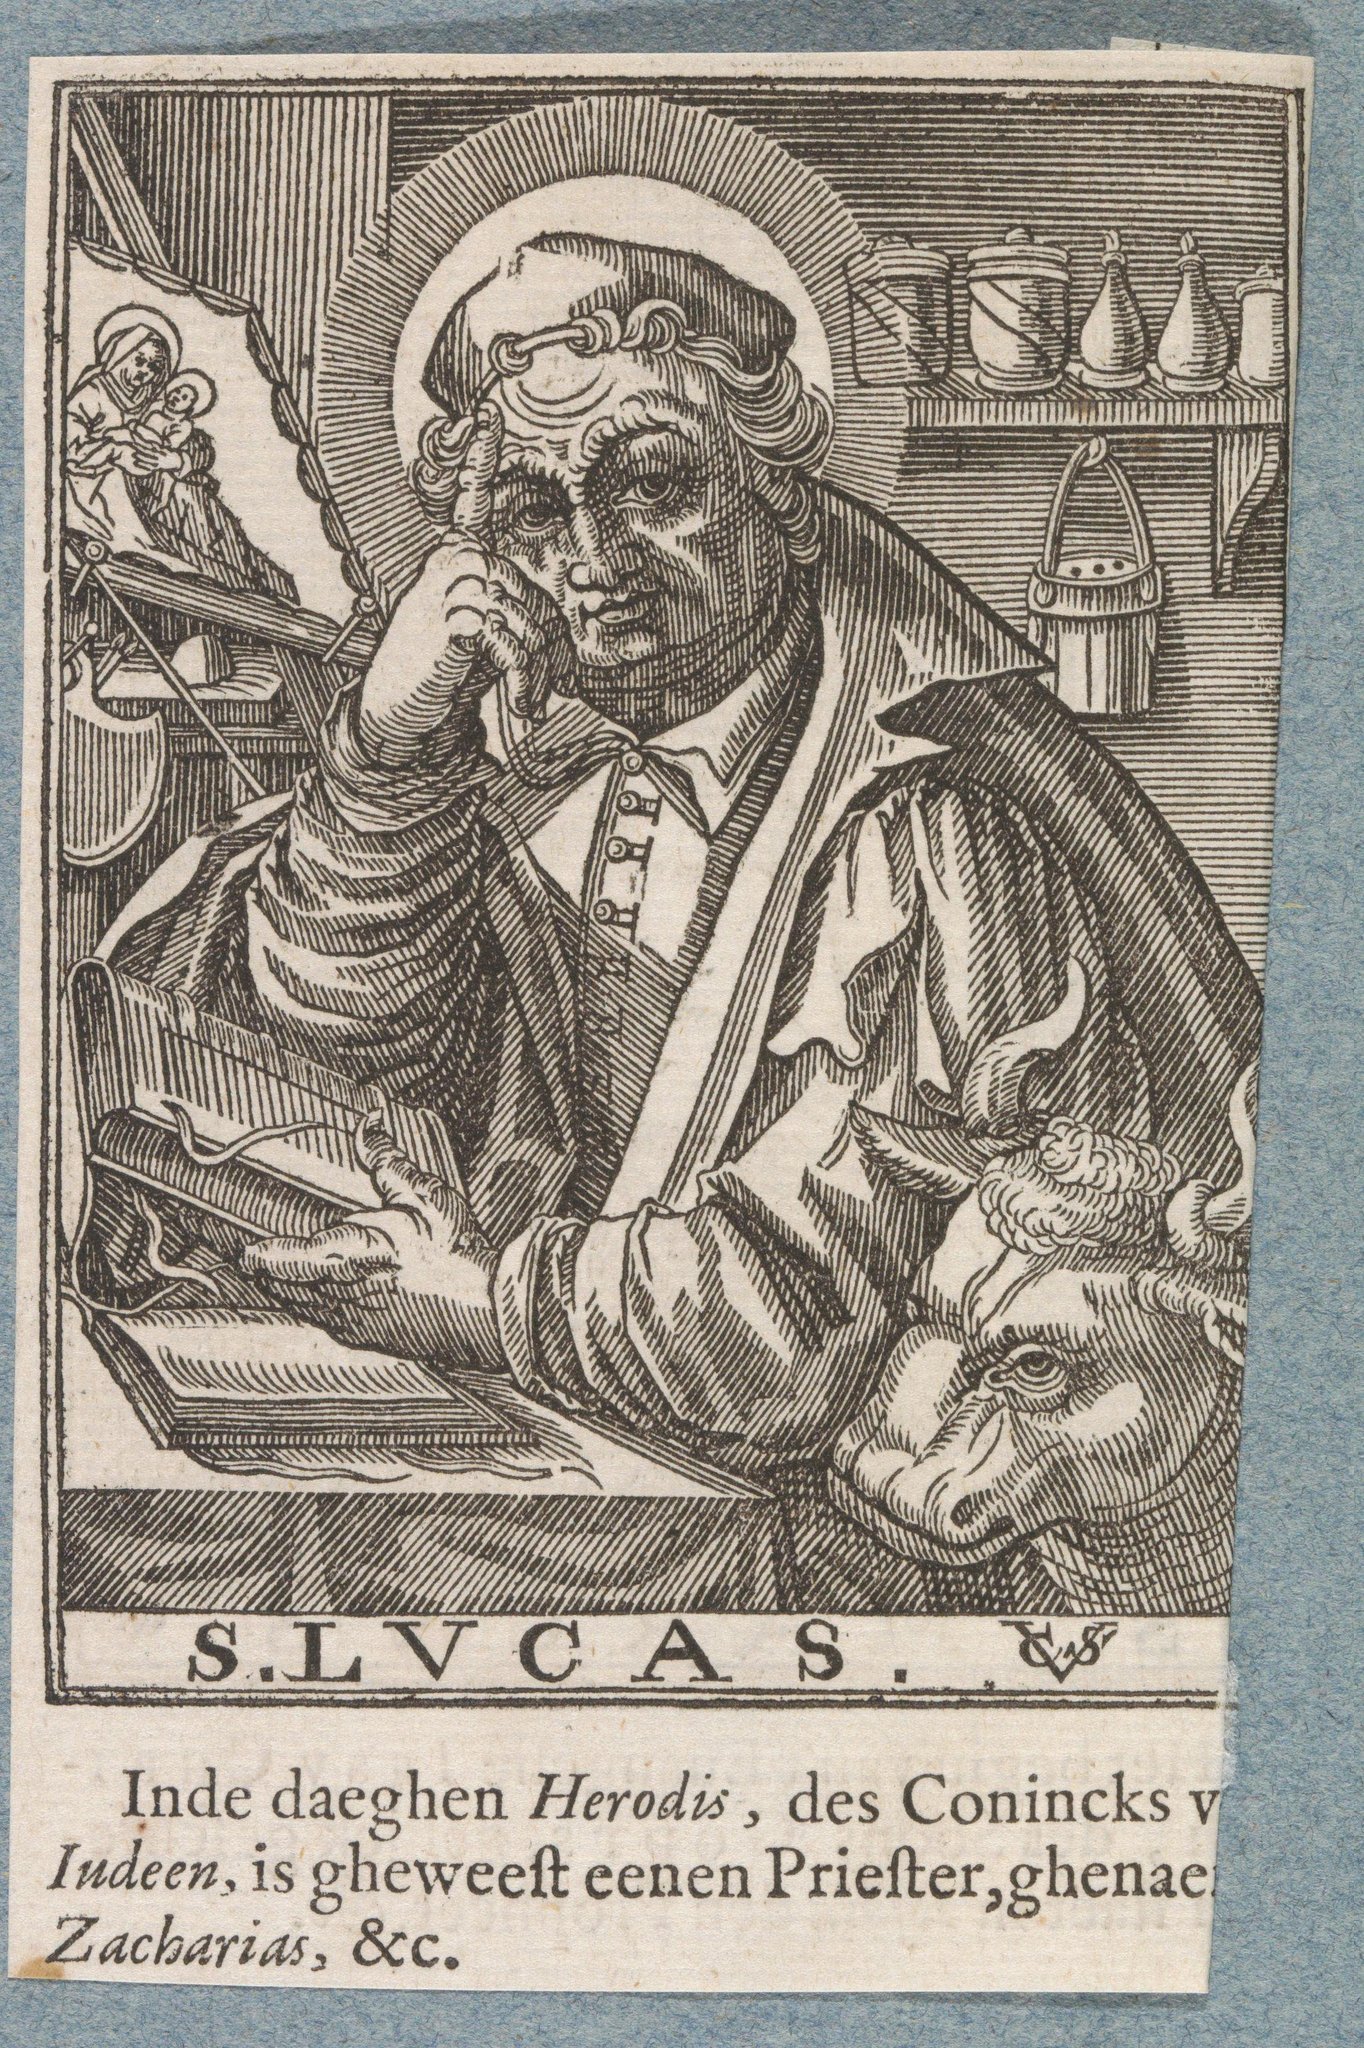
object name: book illustration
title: Evangelist Lucas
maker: pieter jacobsz. paets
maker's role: publisher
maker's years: 1587-1667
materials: paper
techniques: letterpress printing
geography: amsterdam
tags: luke the evangelist; possible attributes: book, (winged) ox, portrait of the virgin, surgical instruments, painter's utensils, scroll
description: Lucas de evangelist aan een tafel met boeken. Zijn hoofd rust op zijn rechterhand. Links een schilderij op een schildersezel met een voorstelling van Maria en Kind. Rechtsonder een os. Daaronder drie regels tekst: Inde daeghen Herodis ... De prent maakt deel uit van een album.